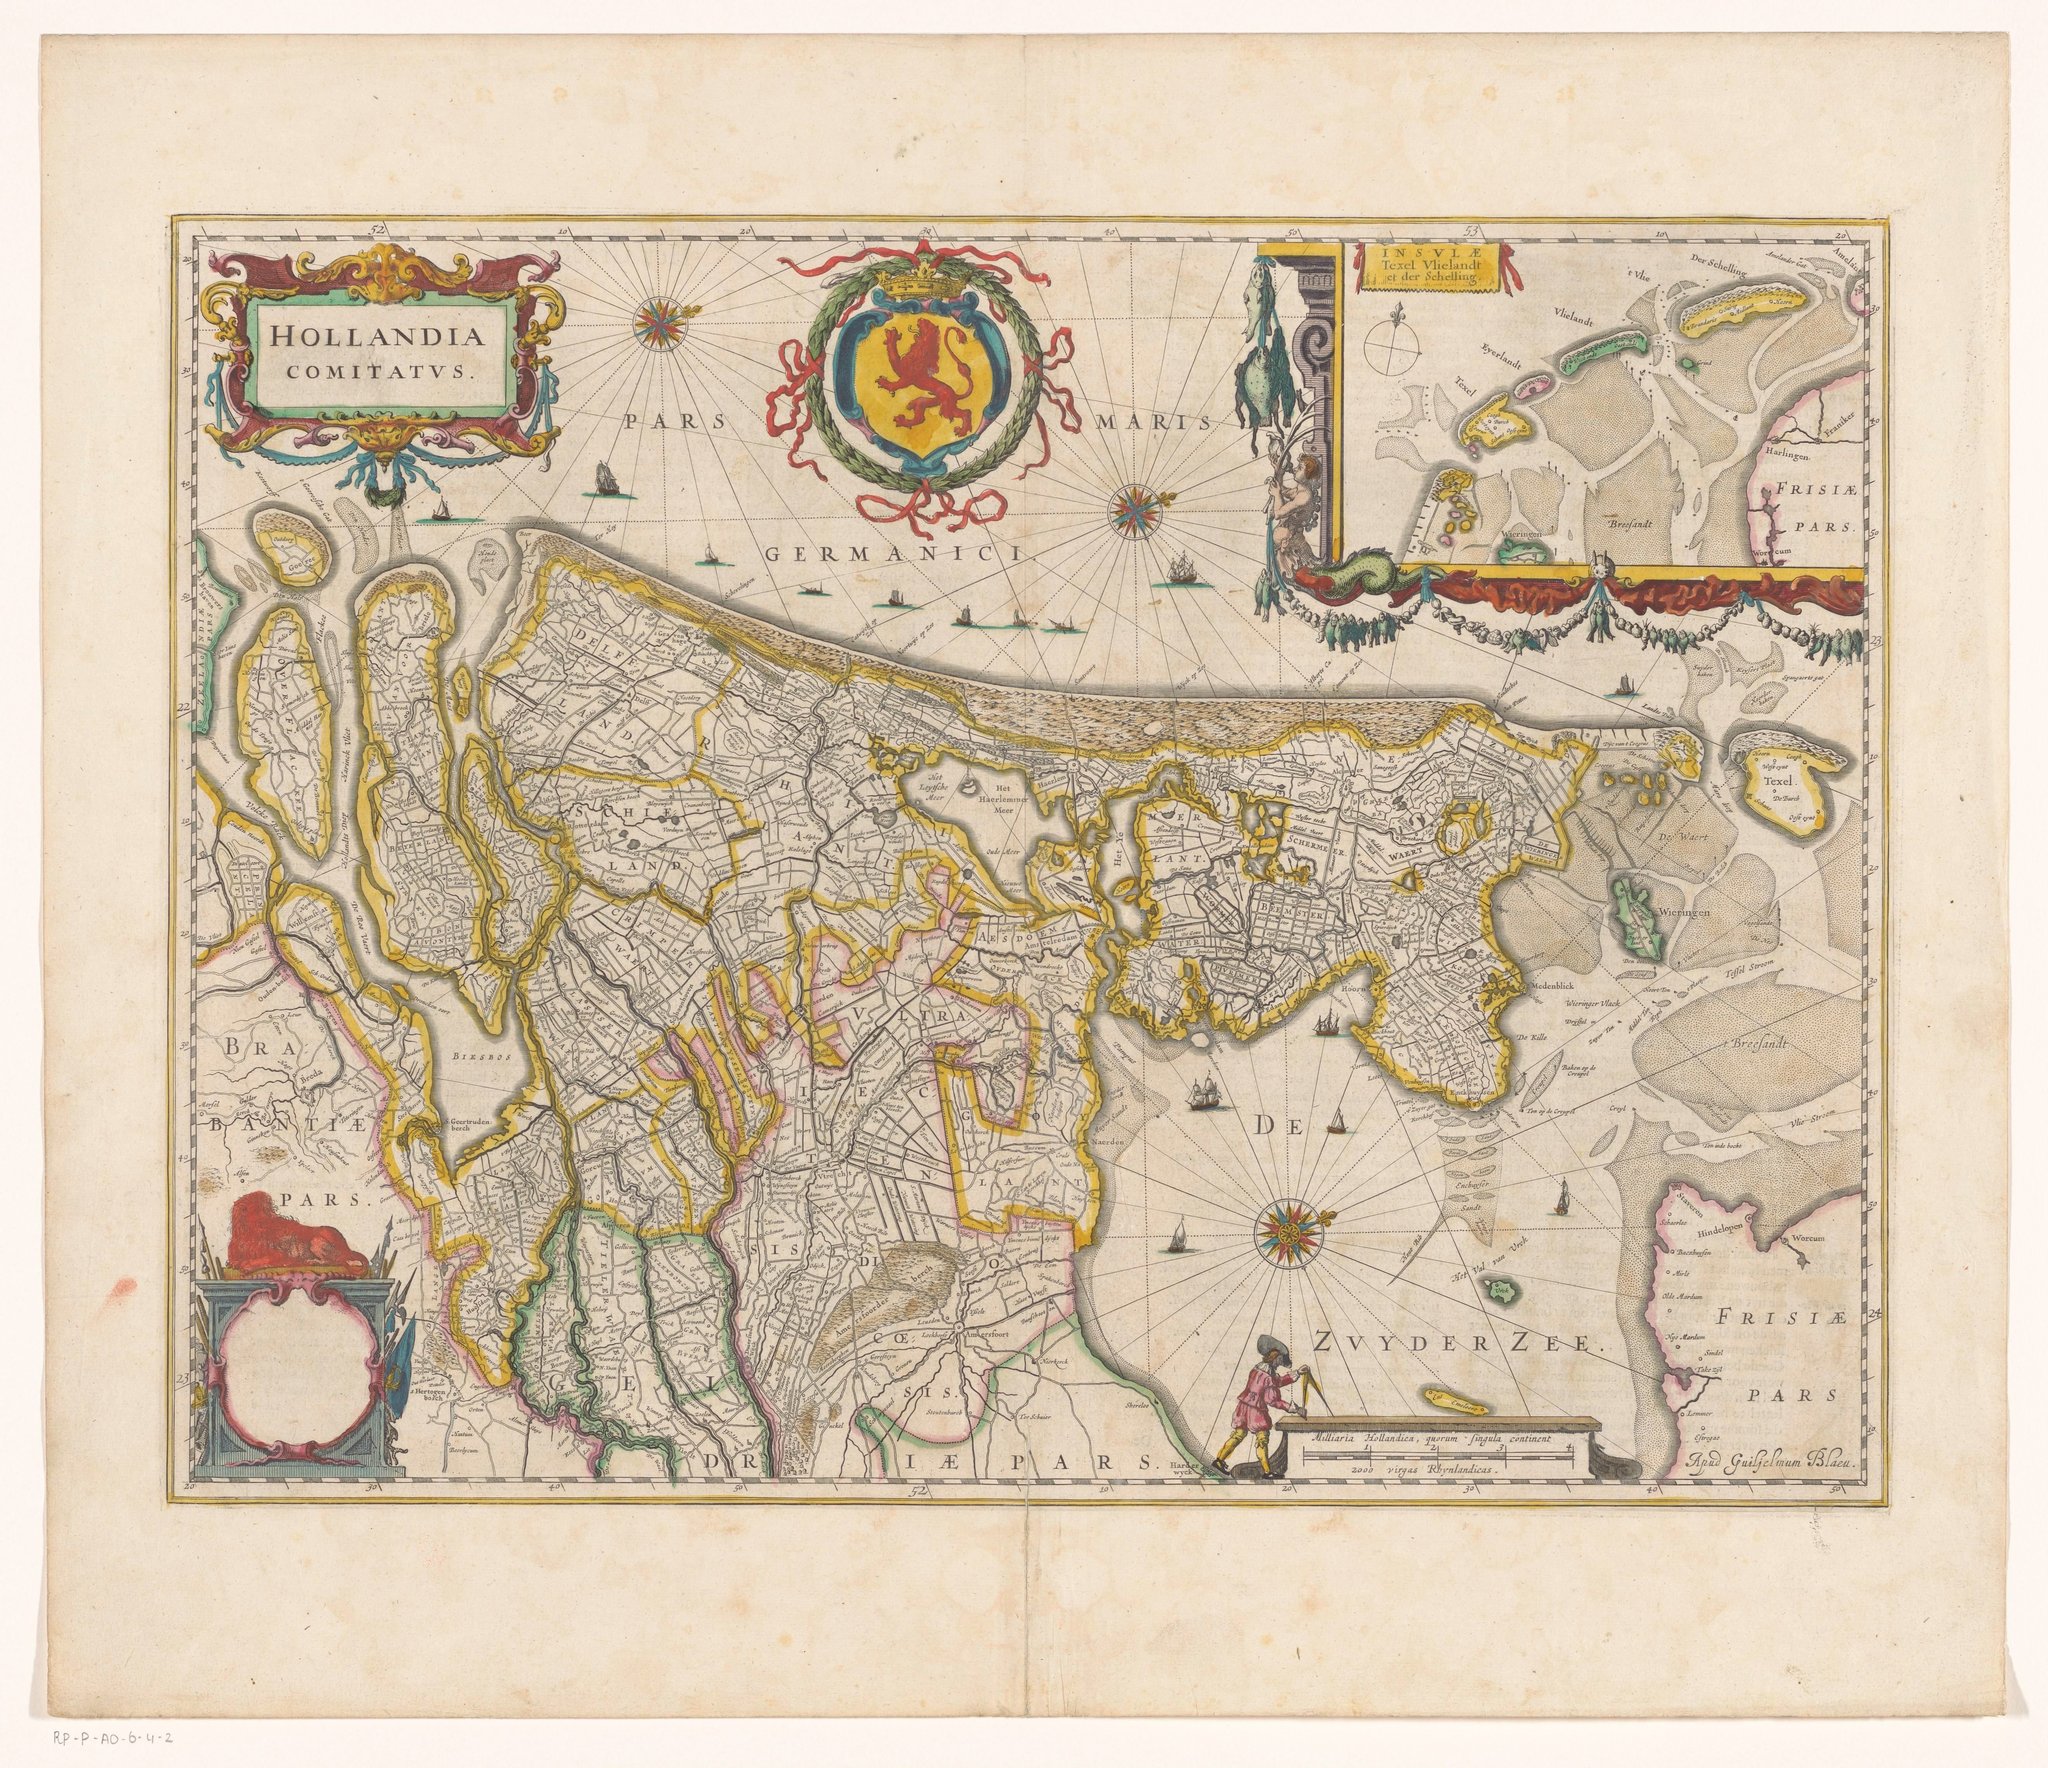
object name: print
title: Hollandia Comitatus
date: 1634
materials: paper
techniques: engraving, etching, hand coloring, letterpress printing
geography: amsterdam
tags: maps of separate countries or regions, coat of arms (as symbol of the state, etc.) (+ province; provincial), holland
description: Prent gebruikt in: Blaeu, Willem Janszoon en Johannes Willemszoon Blaeu. Toonneel des aerdrycx, ofte nieuwe Atlas, dat is de beschryving van alle landen. 4 delen. Amsterdam: Johannes Willemszoon Blaeu, 1647-1650, dl. 1 (1647-1648). Of in: Blaeu, Willem Janszoon en Johannes Willemszoon Blaeu. Toonneel des aerdrycx, ofte nieuwe Atlas, dat is de beschryving van alle landen. 4 delen. Amsterdam: Johannes Willemszoon Blaeu, 1649-1650, dl. 1. Of in: Blaeu, Willem Janszoon en Johannes Willemszoon Blaeu. Toonneel des aerdriicx, ofte niuew Atlas, dat is beschryving van alle landen. 6 delen. Amsterdam: Johannes Willemszoon Blaeu, 1658-1661, dl. 1.